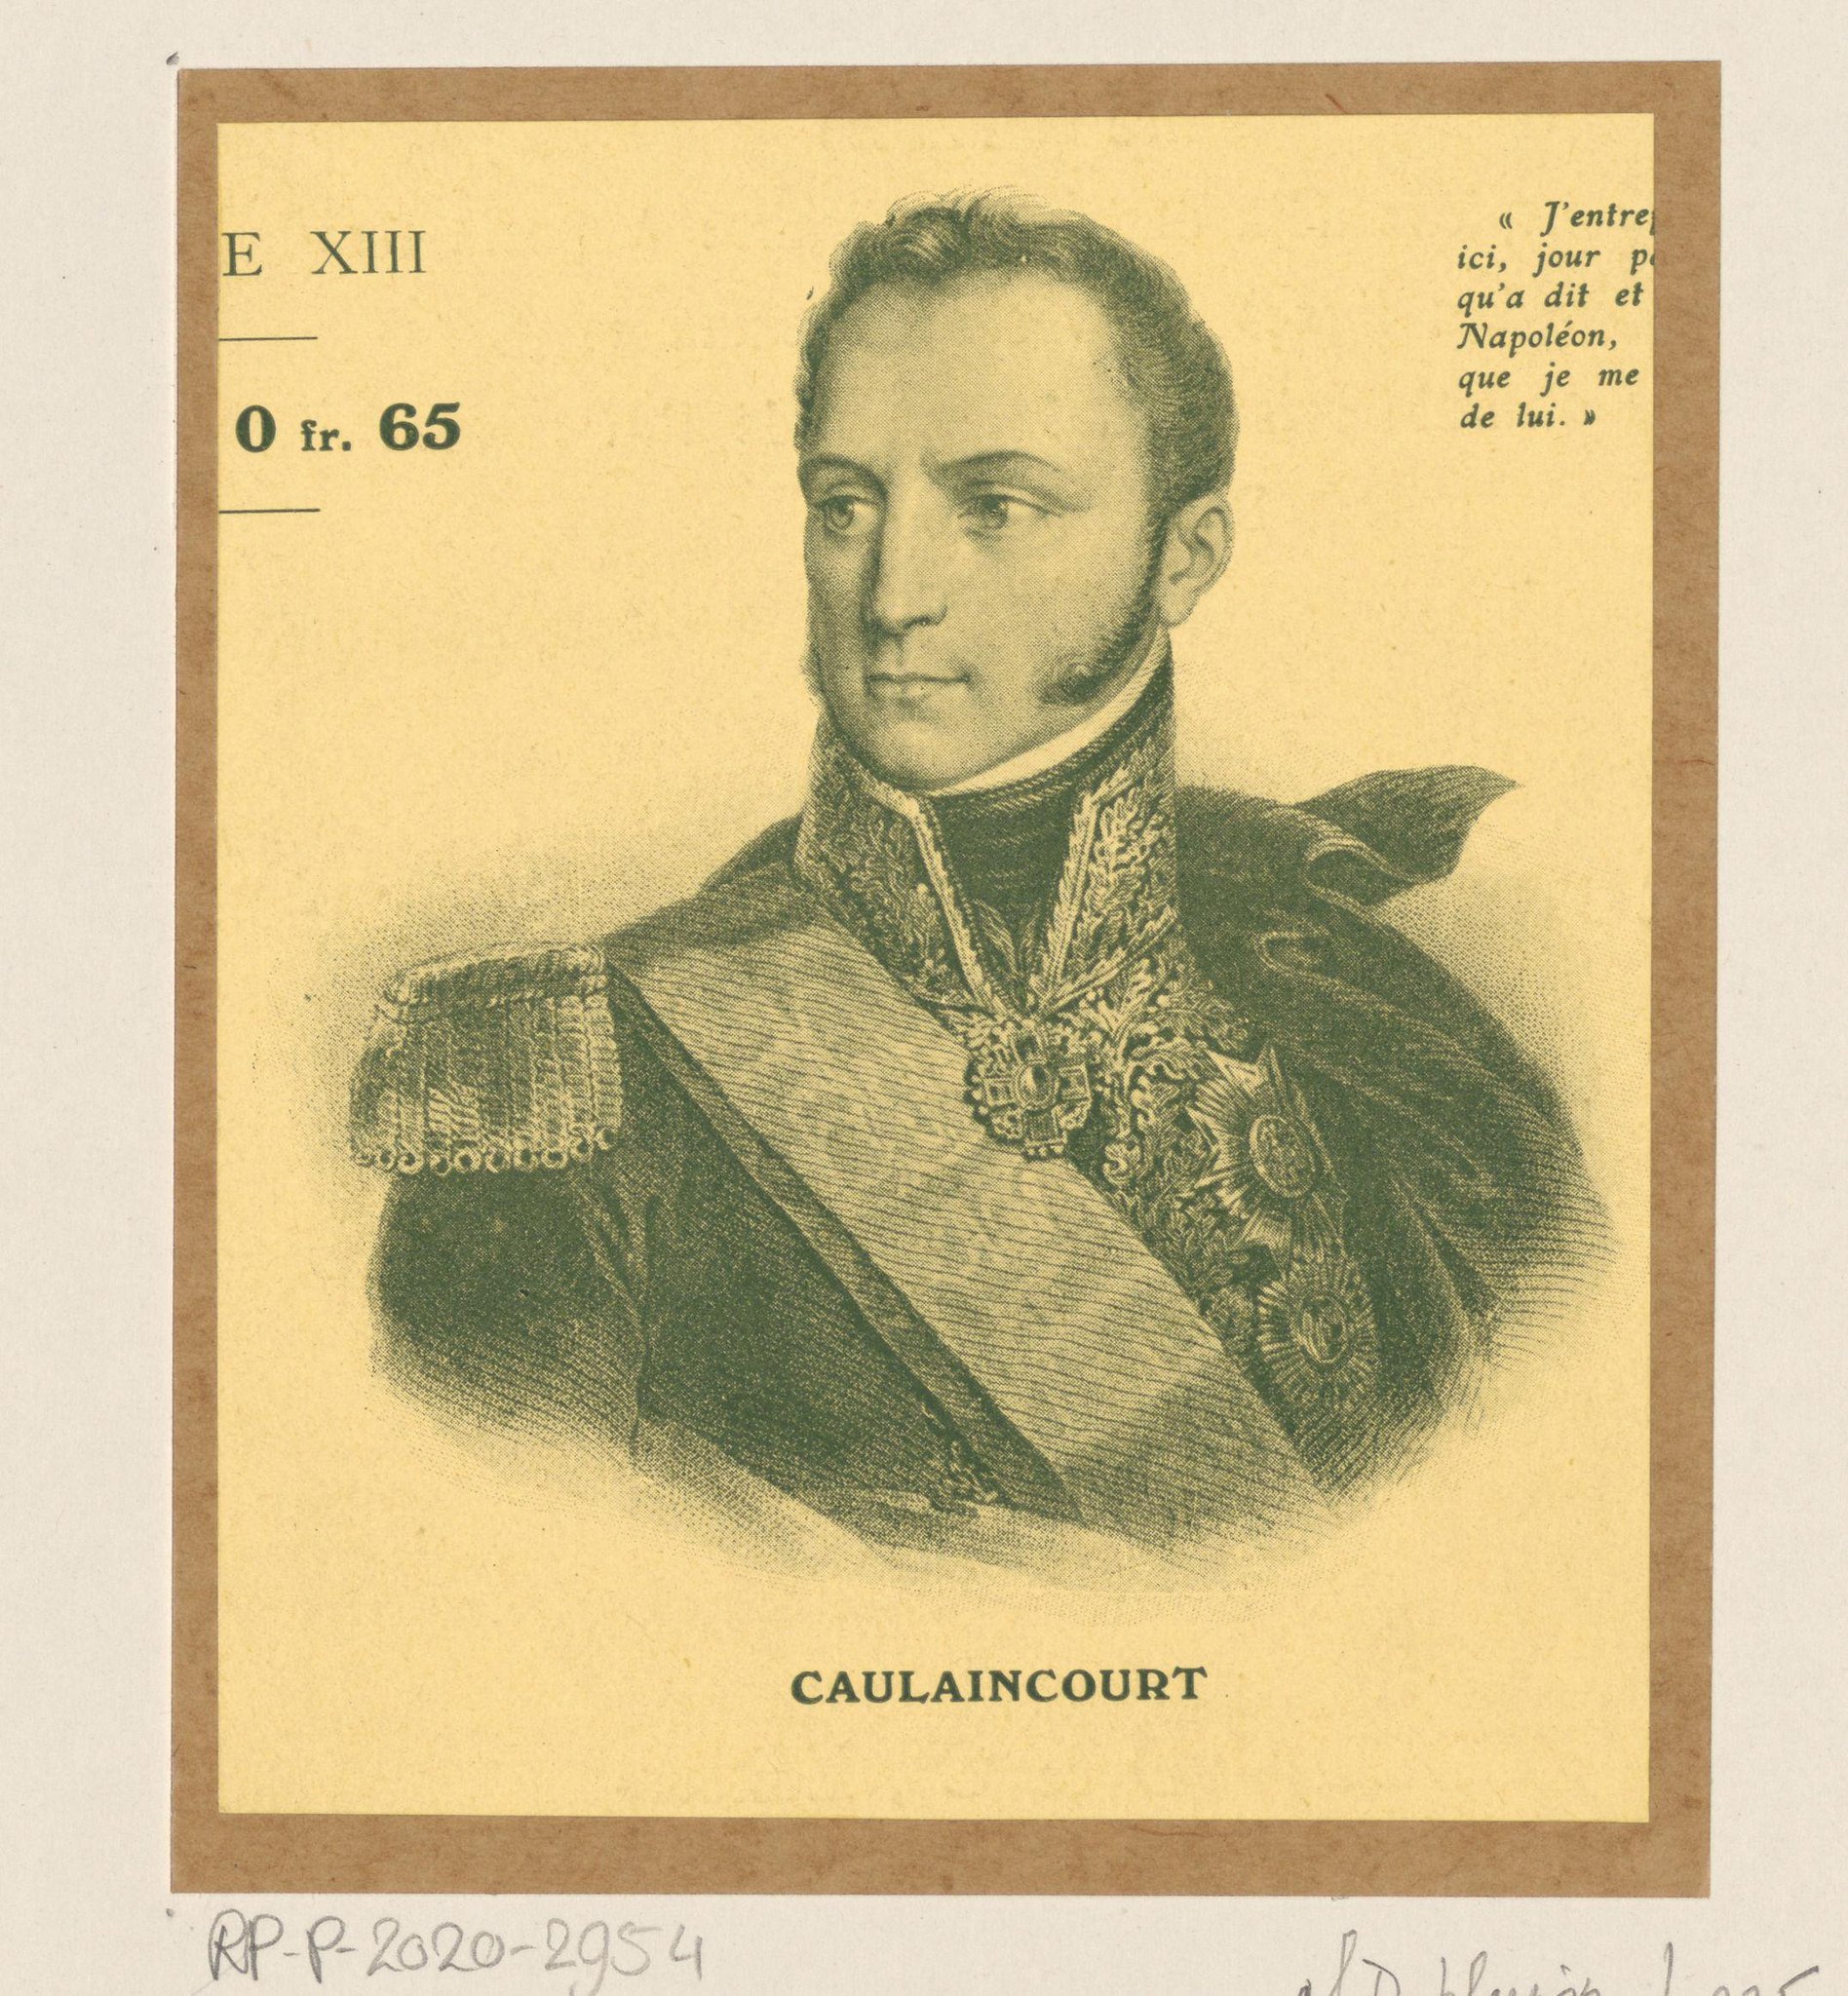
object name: photomechanical print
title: Portret van Armand Augustin Louis de Caulaincourt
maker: Anonymous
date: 1882-1970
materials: paper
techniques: letterpress printing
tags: historical persons